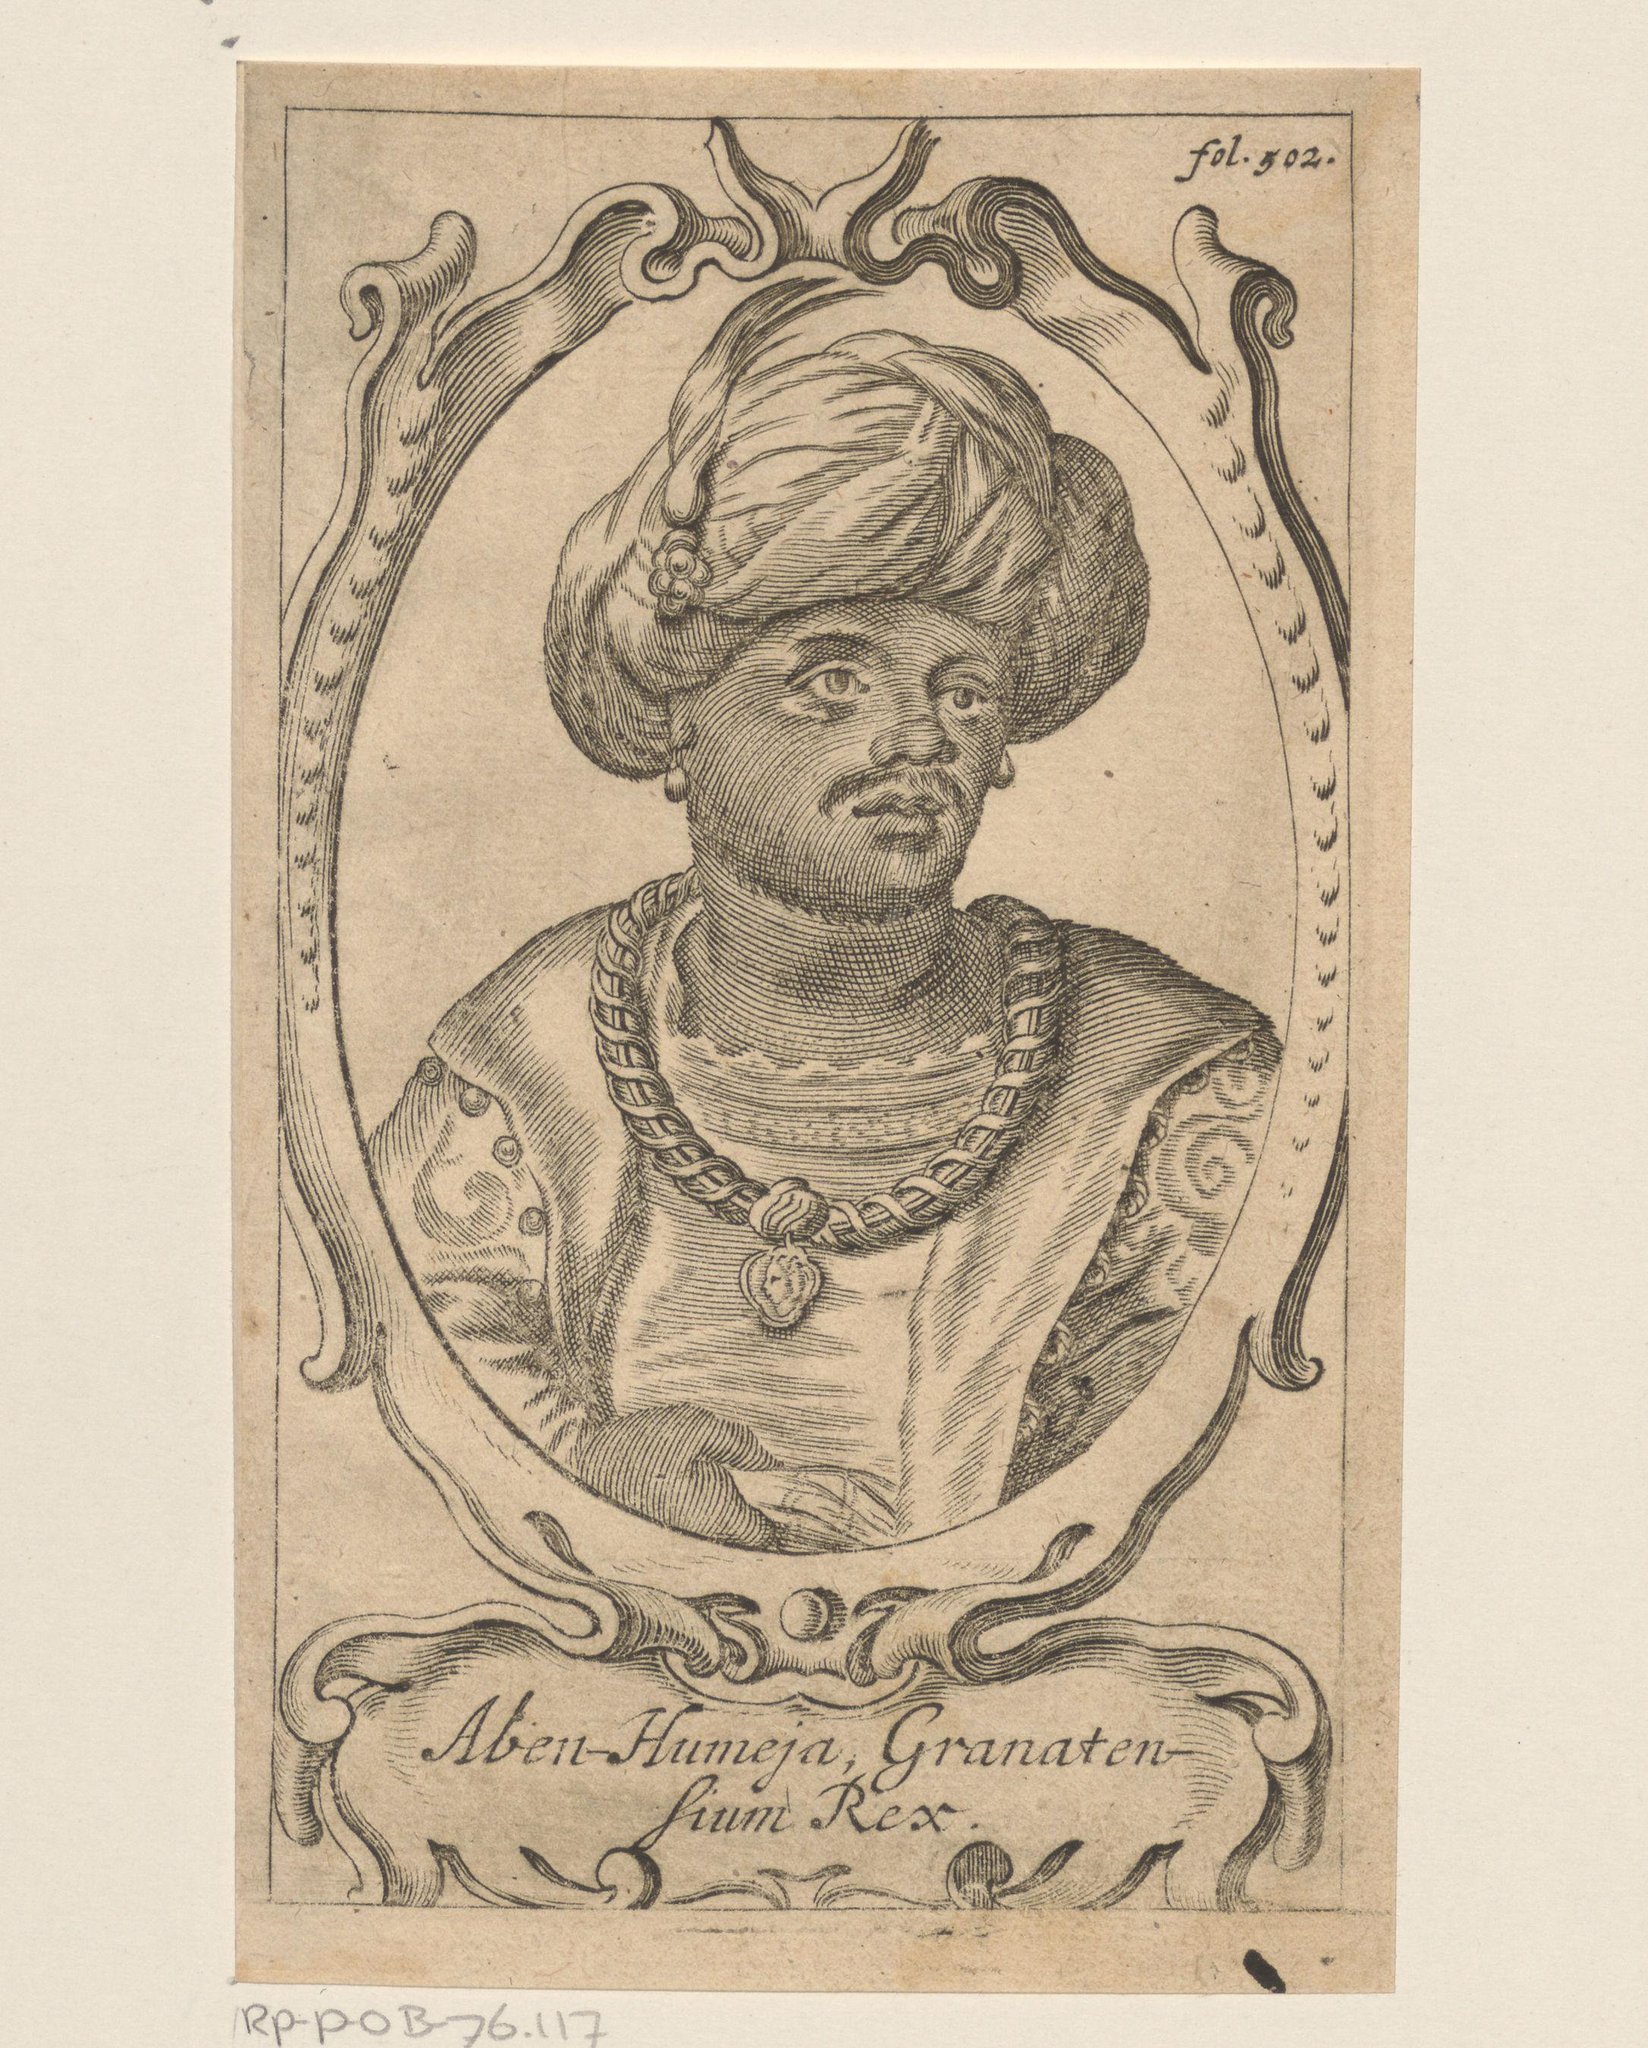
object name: print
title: Portret van Aben Humeya, koning van Granada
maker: Anonymous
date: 1621-1699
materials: paper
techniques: engraving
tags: head-gear: turban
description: Portret van Aben Humeya in een geornamenteerde, ovale omlijsting. Daaronder in een cartouche zijn naam en titel. Rechtsboven: fol. 502.